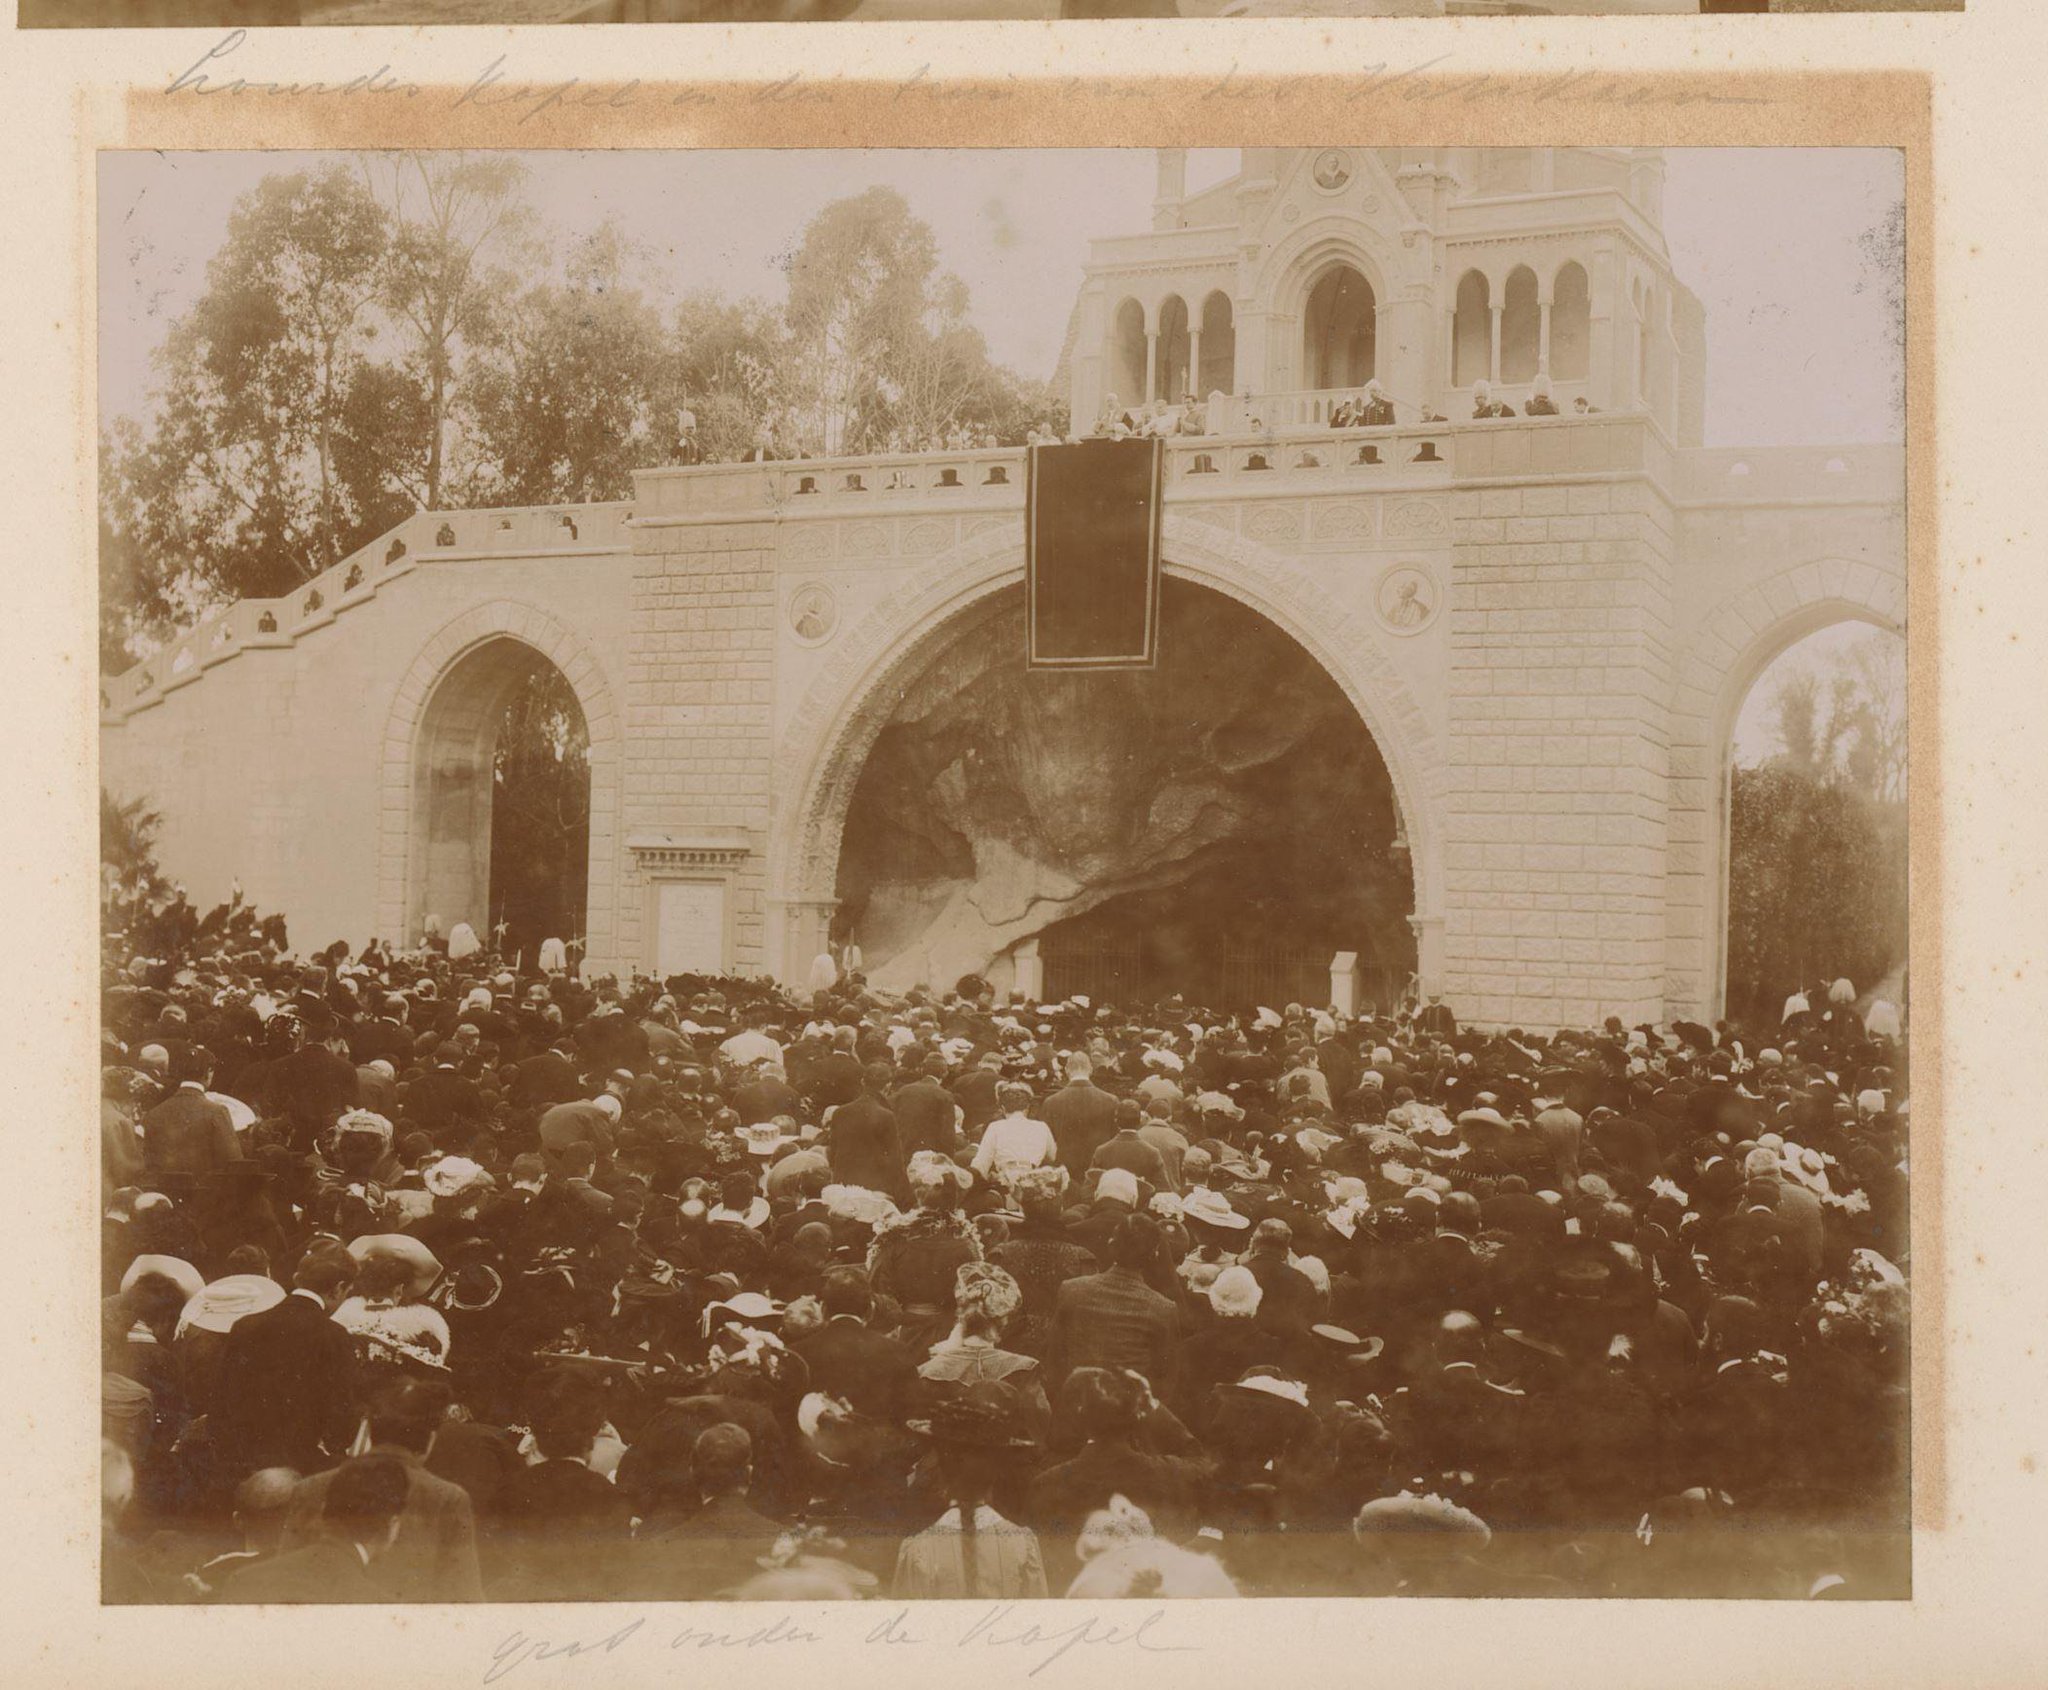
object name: album leaf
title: Openluchtmis voor de Rozenkransbasiliek te Lourdes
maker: Anonymous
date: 1901-1910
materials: paper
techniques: gelatin silver print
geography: lourdes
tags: place of pilgrimage, sacred place, church (exterior), cave, grotto, sermon ~ holy mass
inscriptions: inscription: ‘grot onder de kapel’